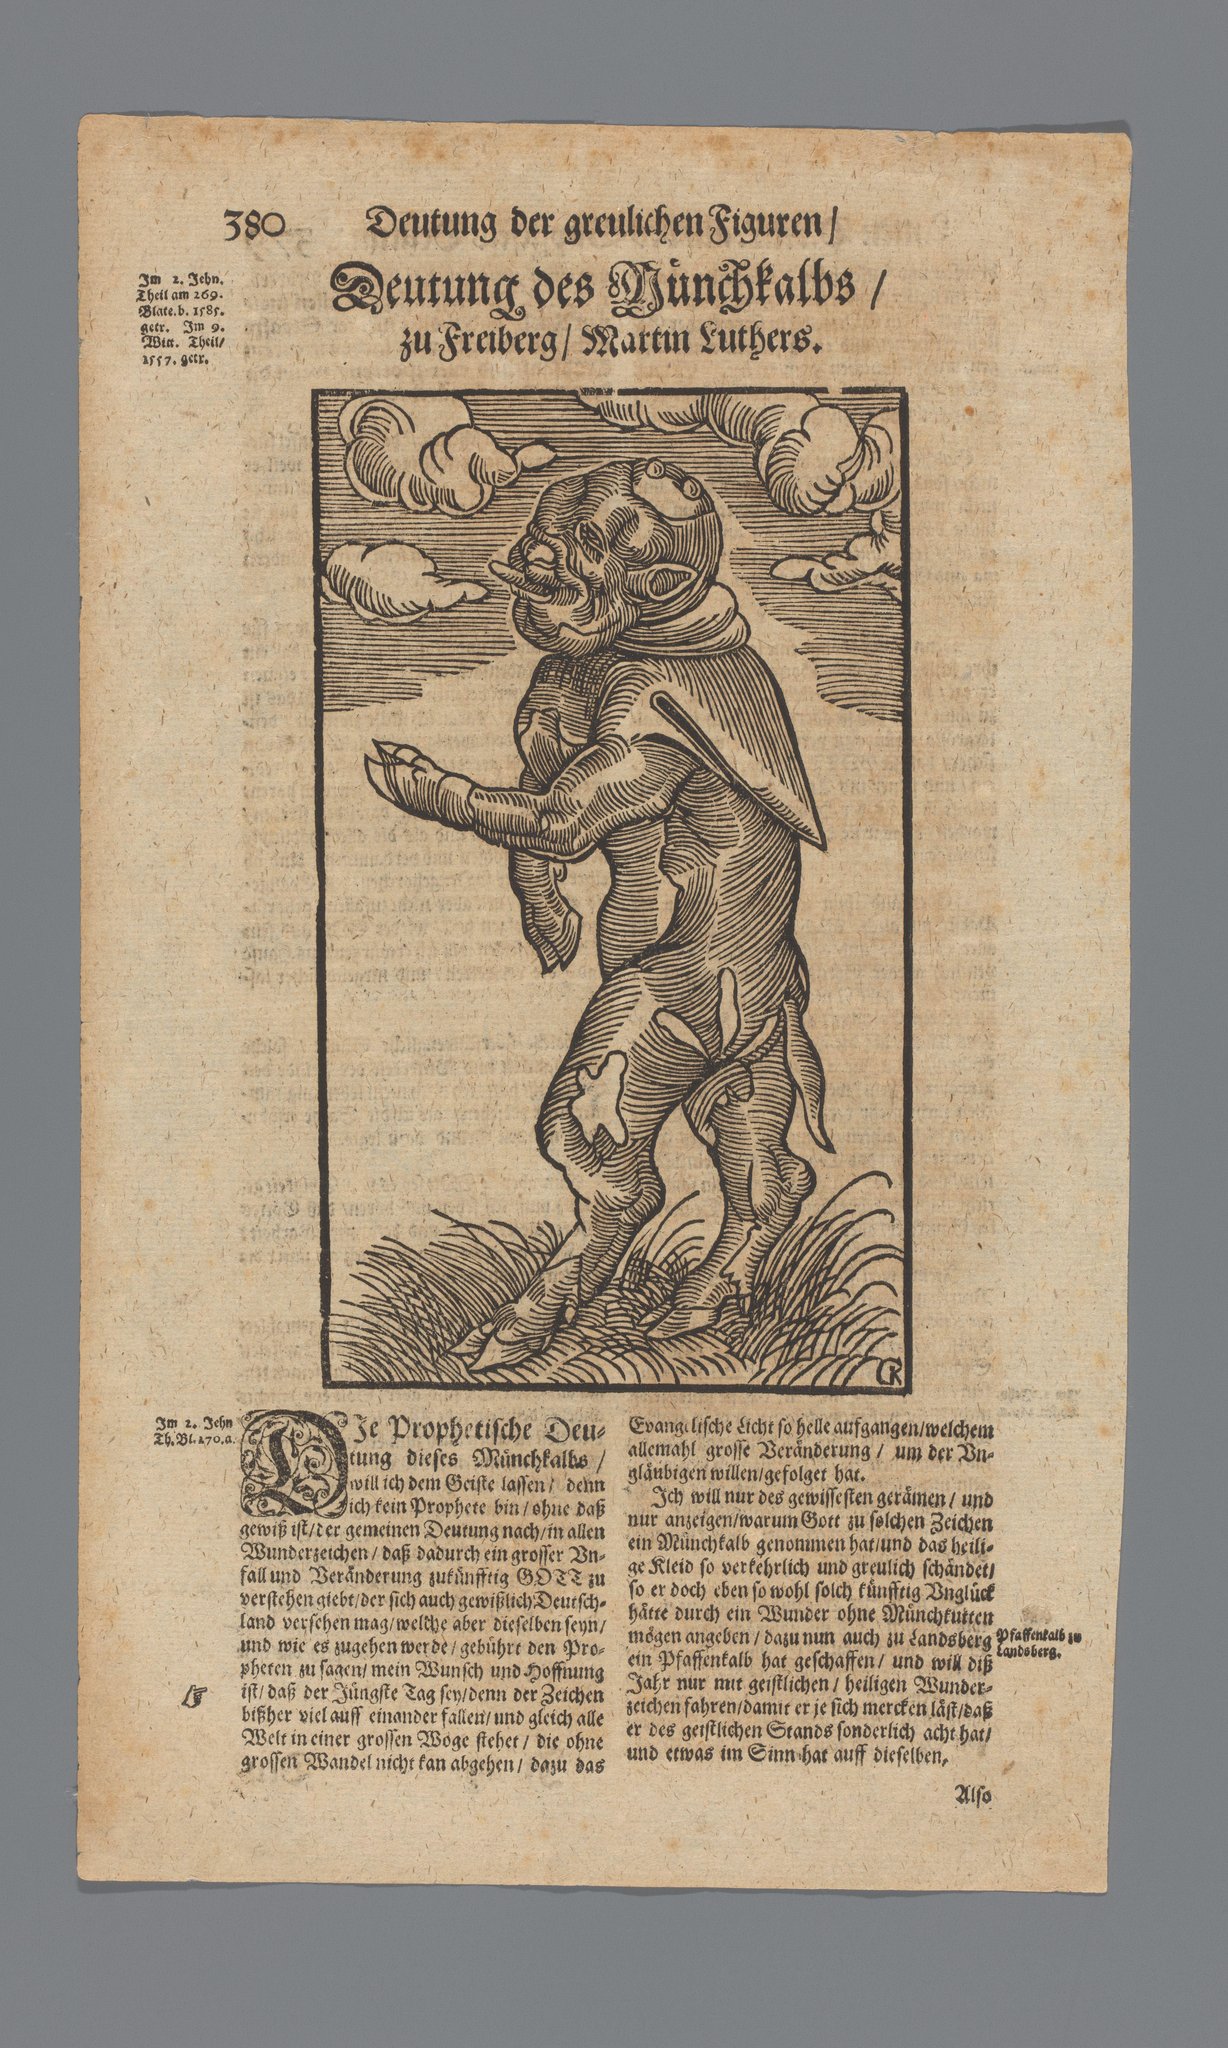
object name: print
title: Mismaakt kalf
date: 1661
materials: paper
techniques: woodcut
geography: europe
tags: priest, martin luther, monsters of mixed human and animal shape; 'mostri' (ripa), monk(s), friar(s), calf, mis-shapen animals; monsters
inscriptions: collector's mark: Lugt 2228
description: Duitse prent met een reformatorische interpretatie van de zgn. Münchkalbs (Mönchskalbs), een mismaakt kalf met de gedaante van een monnik, geboren te Freiburg in 1523. Met uitleg door Martin Luther van de betekenis van deze abnormale gebeurtenis in de context van de Reformatie, onder en op de achterzijde van de houtsnede. Blad genummerd linksboven 380. Spiegelbeeldige kopie naar de prent van Lucas Cranach.